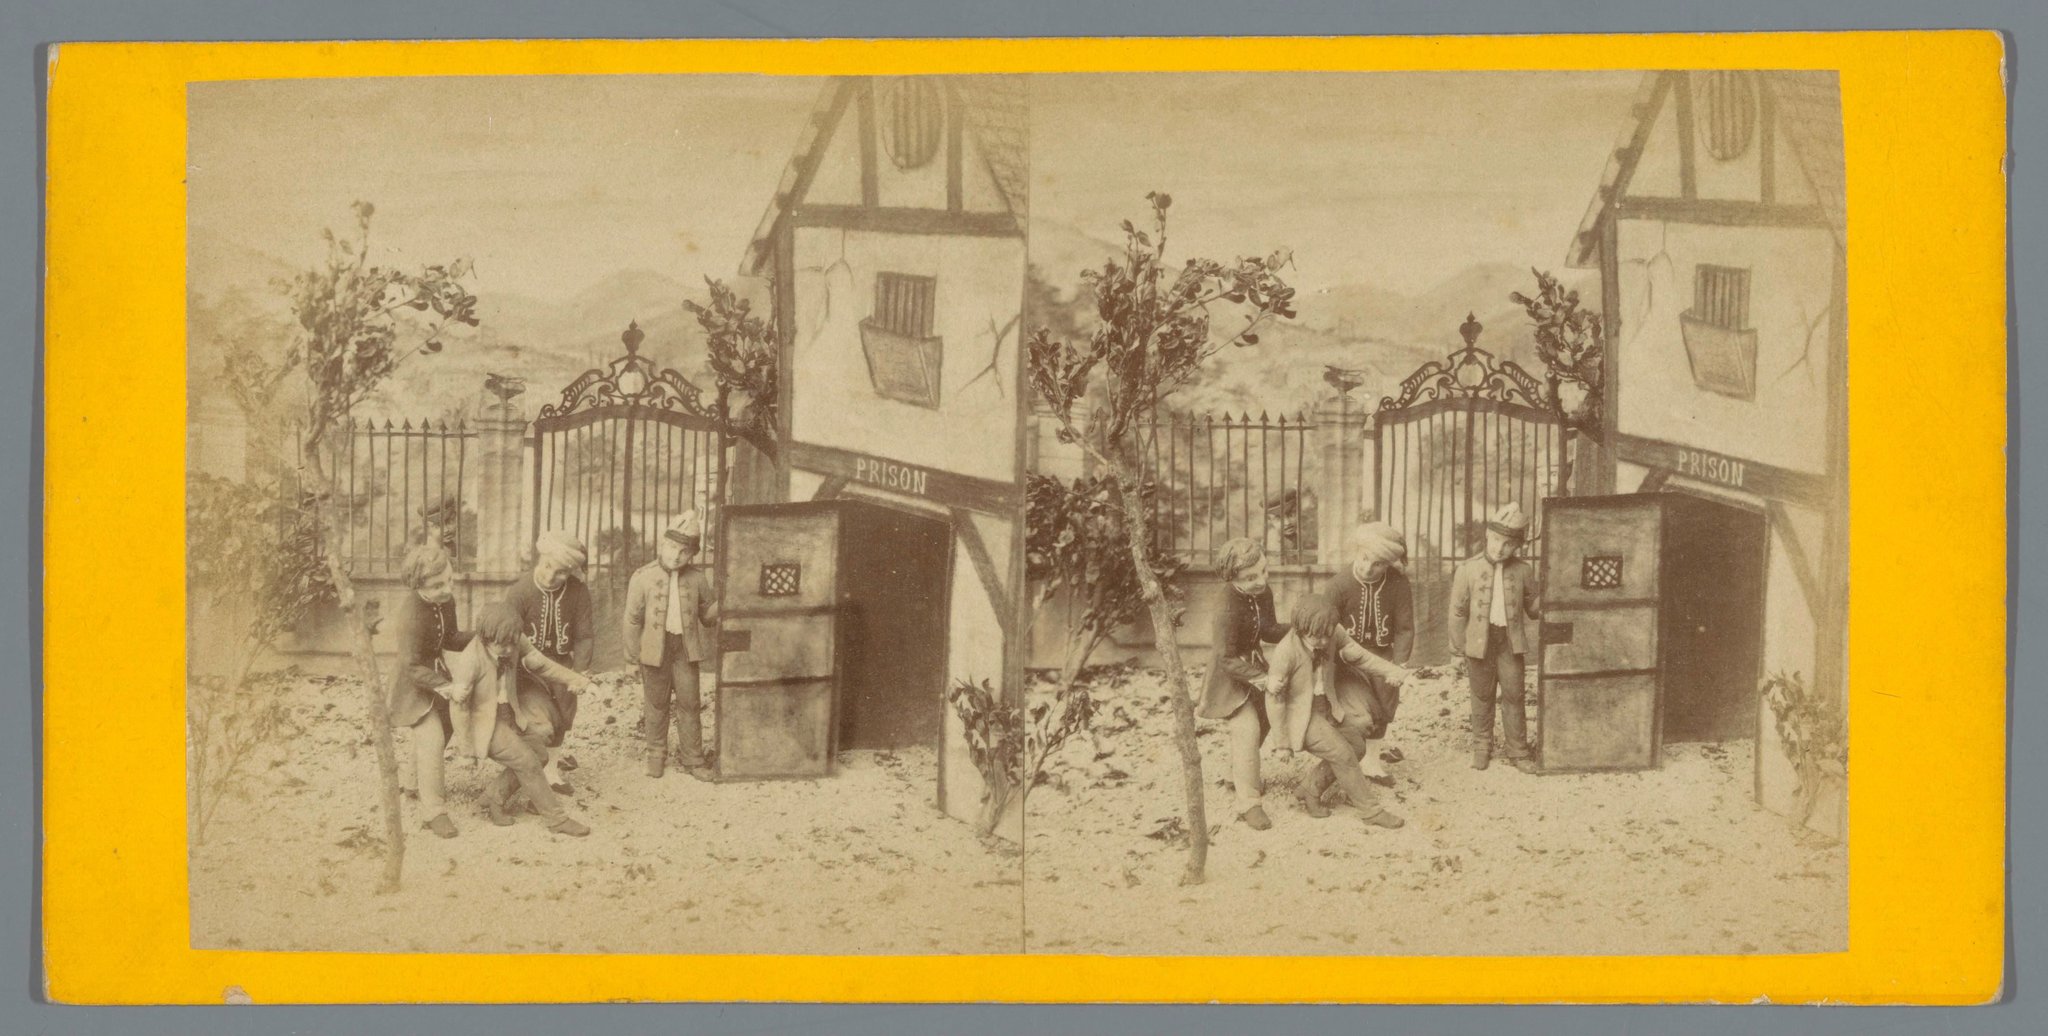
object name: stereograph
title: Enscenering van poppen in een decor, voorstellend een gevangene die een gevangenis wordt ingeleid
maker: Anonymous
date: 1850-1880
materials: cardboard, photographic support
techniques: albumen print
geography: europe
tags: prison, jail, (playing with) dolls, europe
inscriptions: number: ‘10’